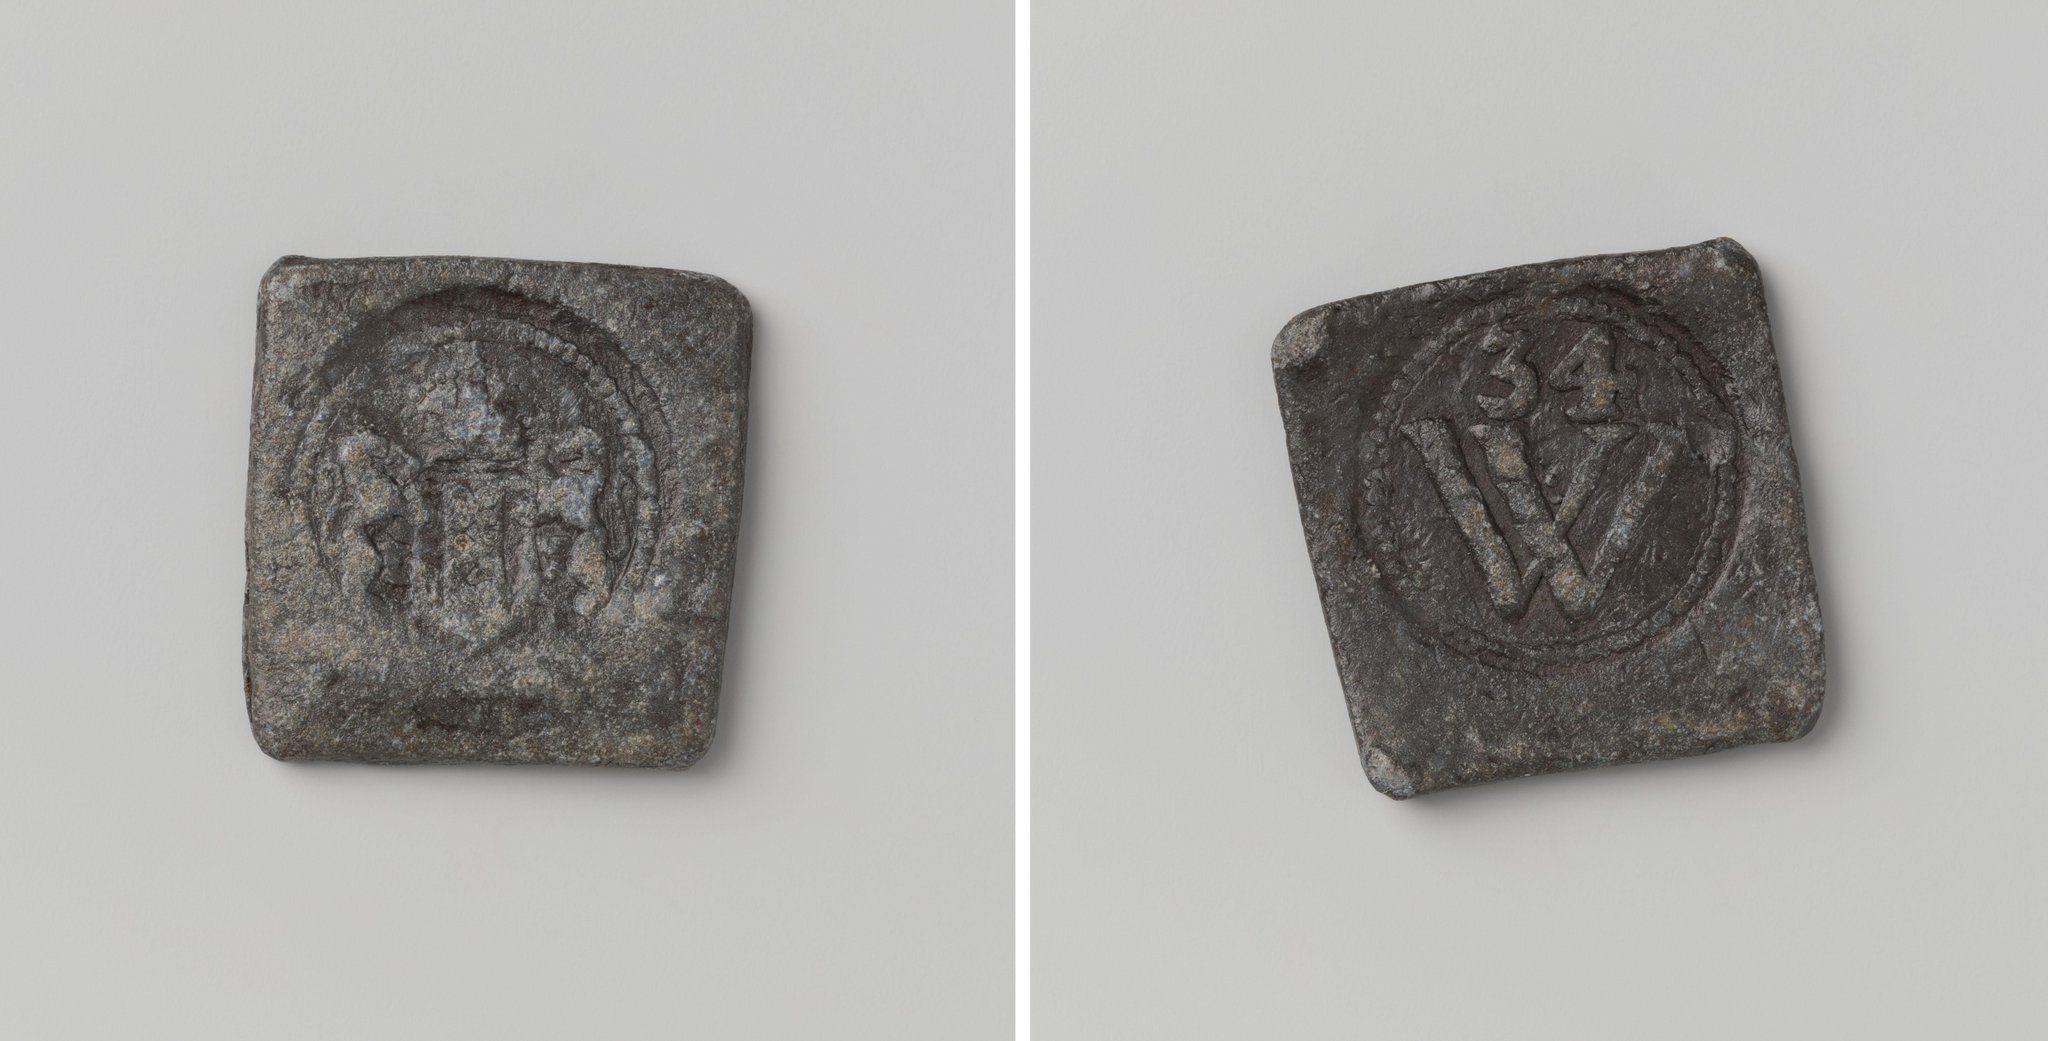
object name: broodpenning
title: Stad Amsterdam, wijk 34, armenpenning die recht gaf op roggebrood tegen een prijs van achteneenhalve stuiver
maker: Anonymous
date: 1662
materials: lead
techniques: casting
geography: amsterdam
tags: amsterdam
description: bijna ruitvormige loden penning. Voorzijde: in ronde stempel: gekroond wapenschild, geflankeerd door twee leeuwen binnen ronde parelrand. Keerzijde: in ronde stempel: cijfer 34 boven letter W binnen ronde parelrand